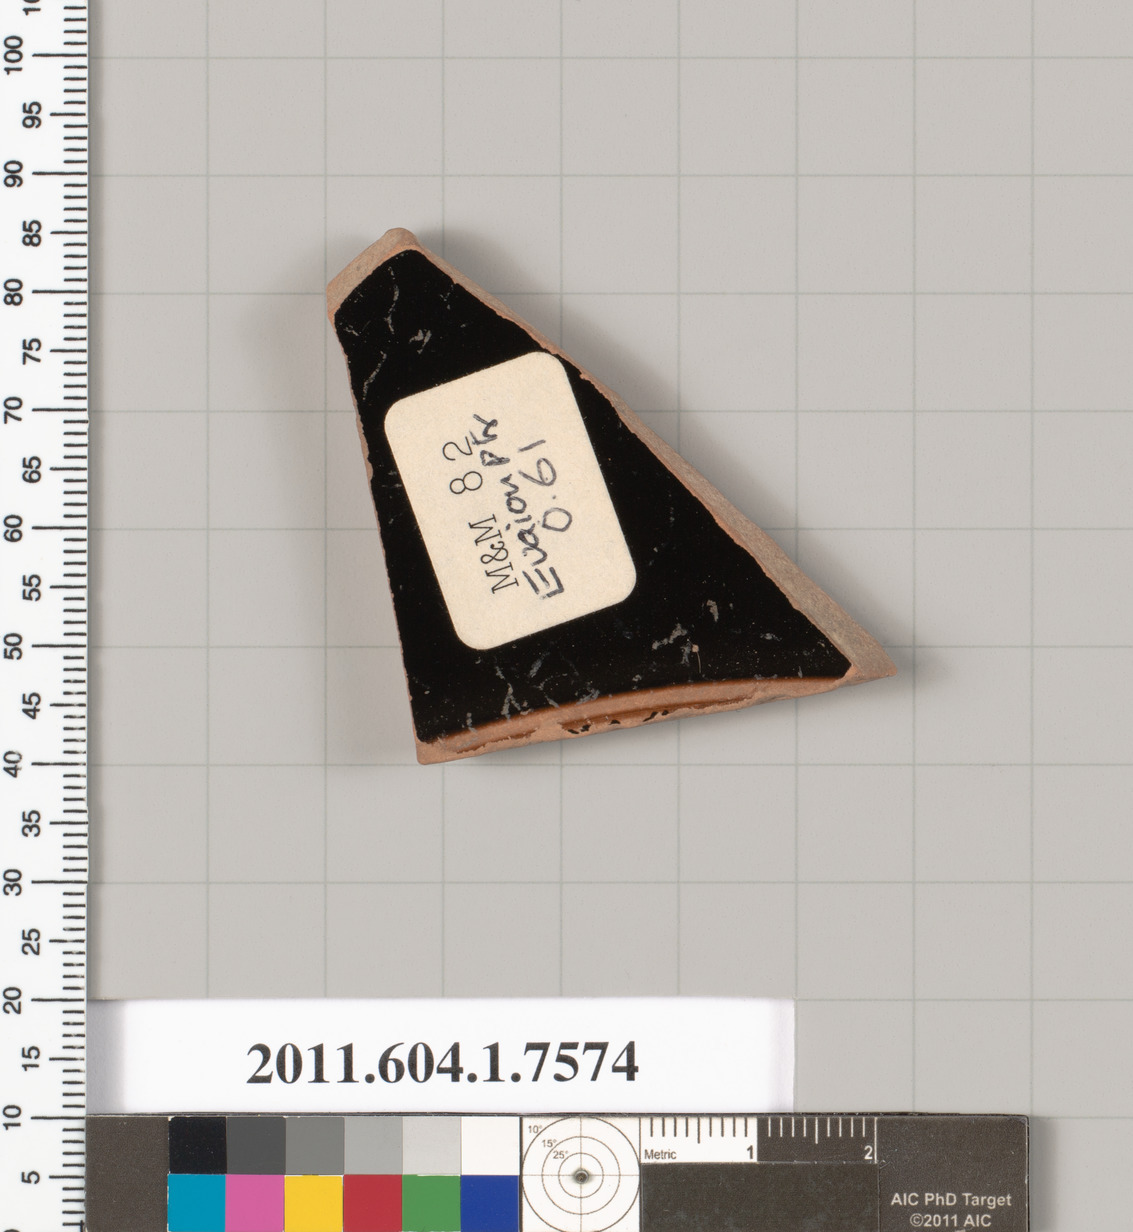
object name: kylix fragment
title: Terracotta fragment of a kylix (drinking cup)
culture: greek, attic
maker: euaion painter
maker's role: artist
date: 460-450 BCE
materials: terracotta